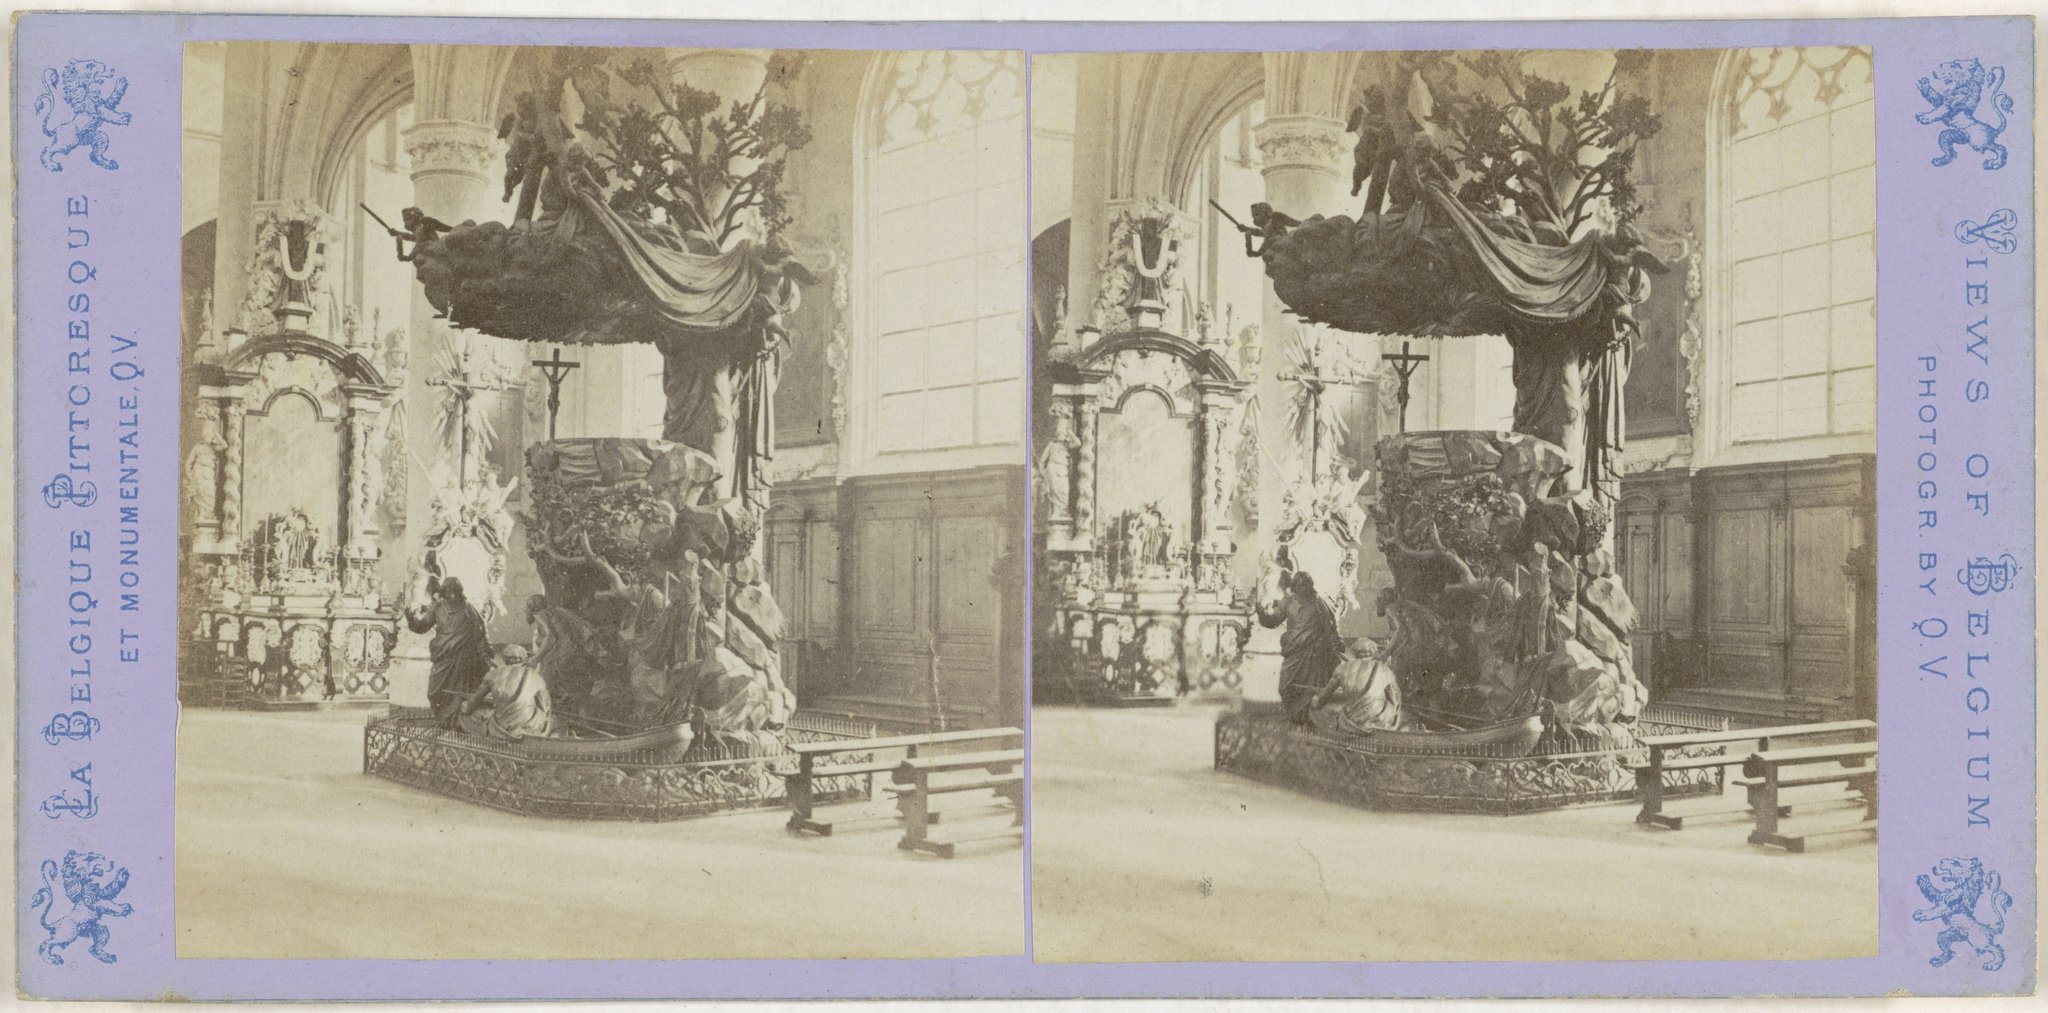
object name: stereograph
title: La Belgique pittoresque et monumentale / Views of Belgium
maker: jules hippolyte quéval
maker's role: publisher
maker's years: 1824-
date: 1866-1870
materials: cardboard, paper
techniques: albumen print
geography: antwerp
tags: pulpit, ambo, chancel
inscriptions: number: ‘No 1663’